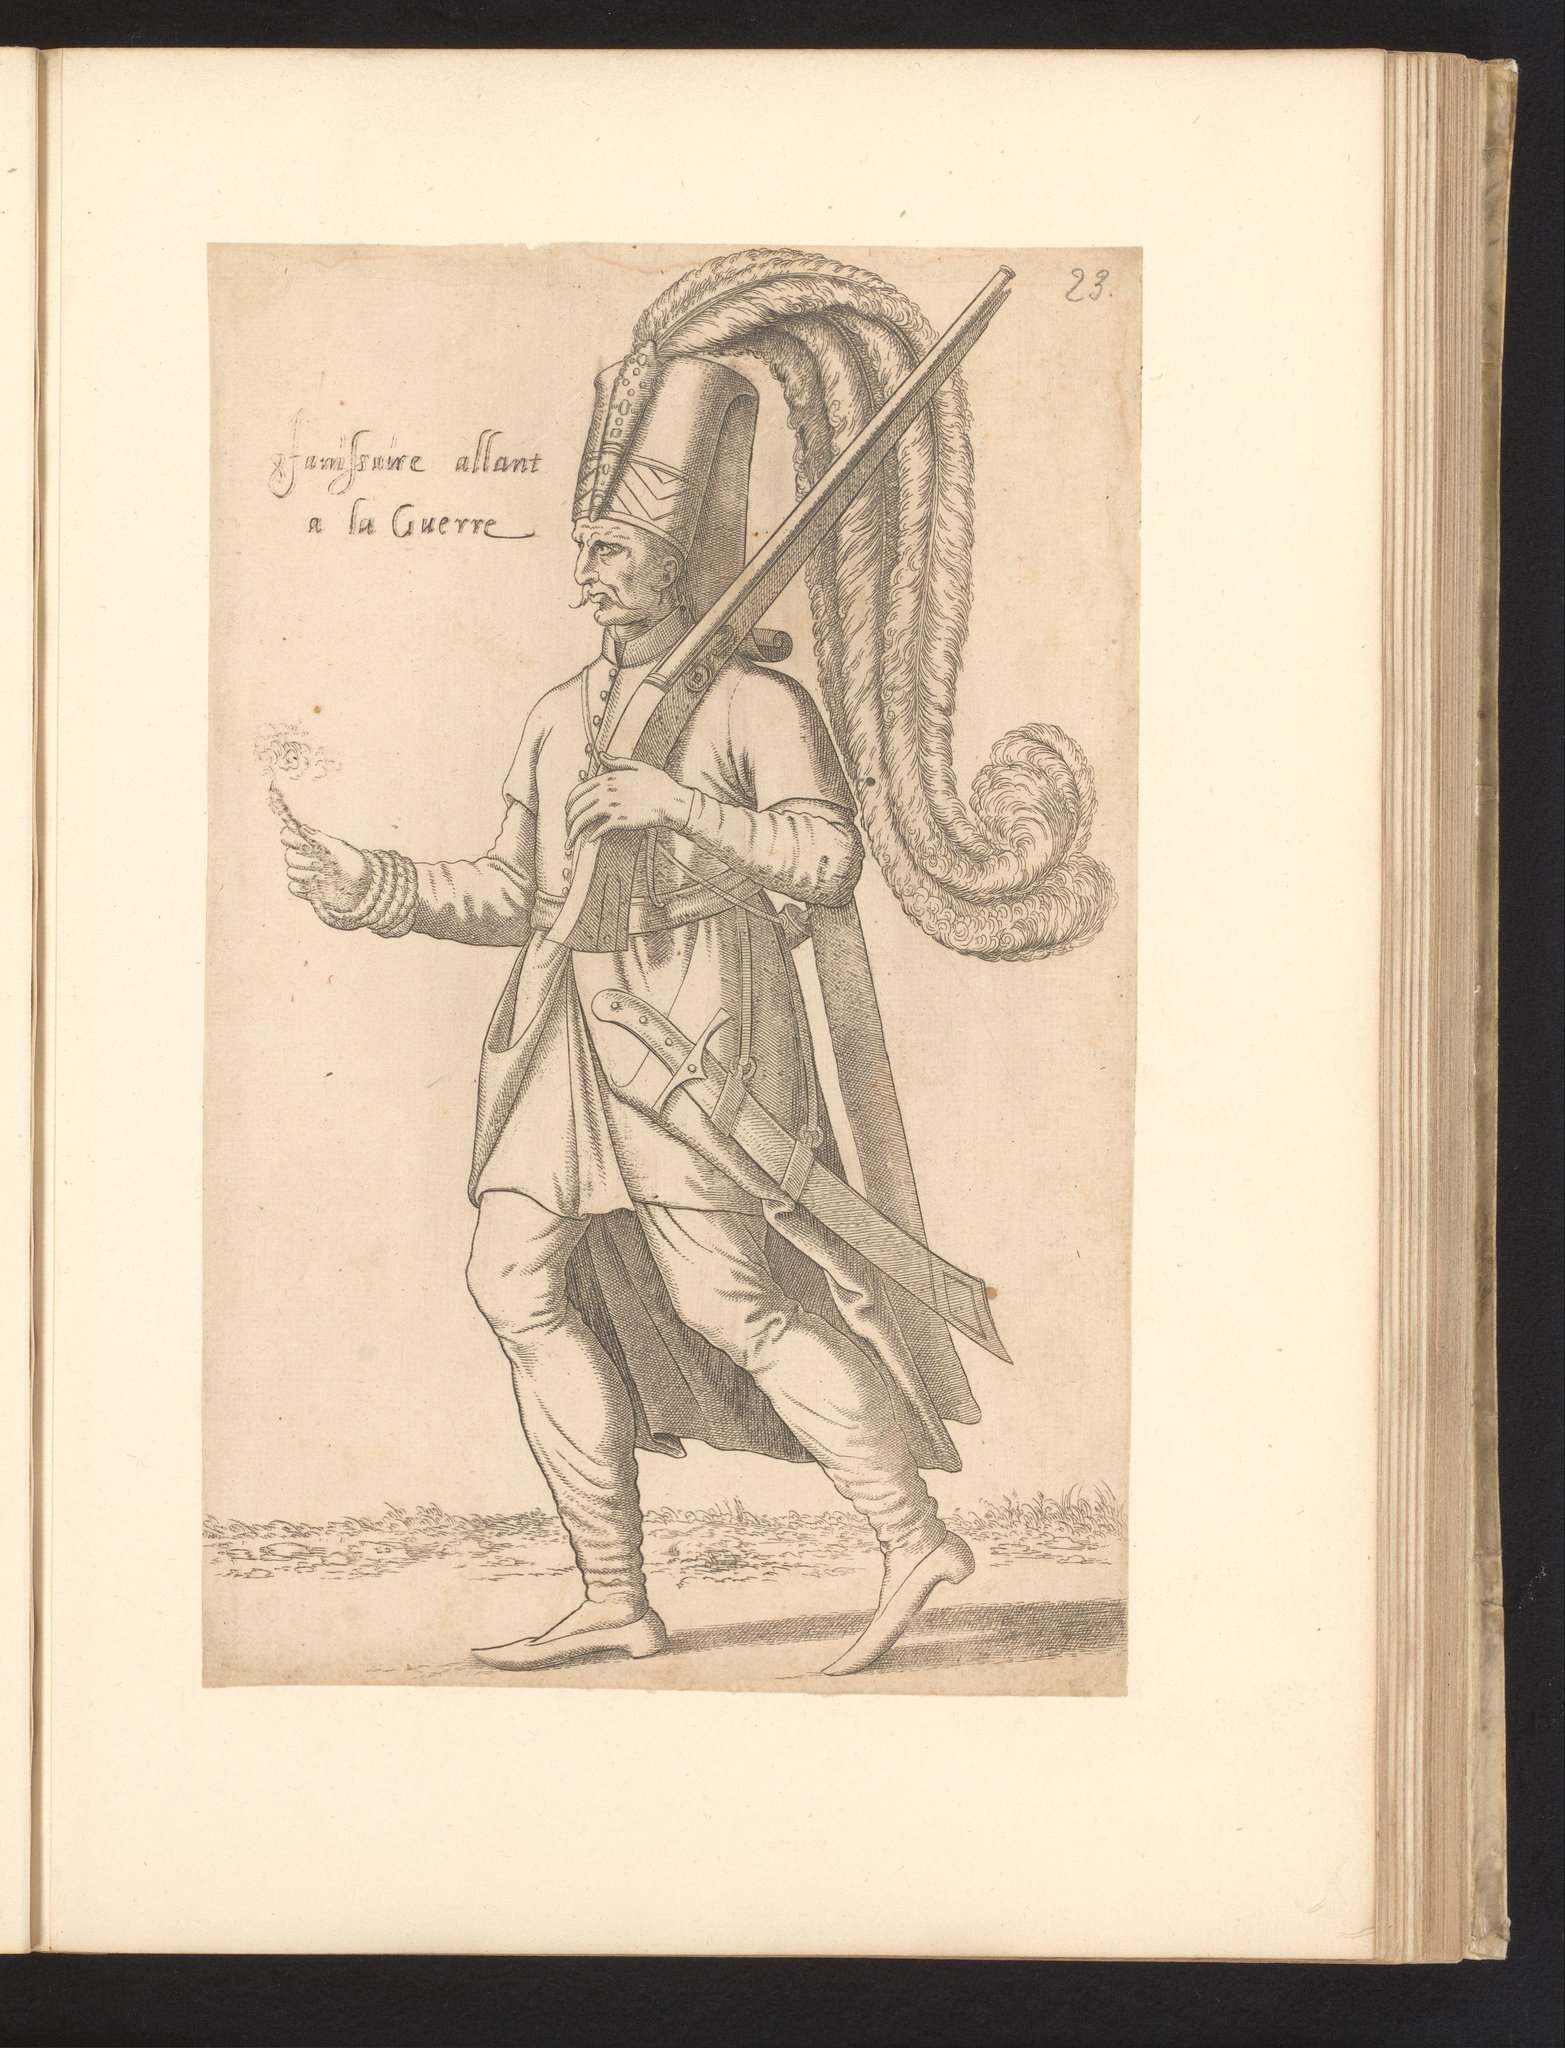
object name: book illustration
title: Janissaire allant à la guerre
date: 1555-1568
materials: paper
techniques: etching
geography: lyon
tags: private soldier (+ infantry), firearms: rifle, asiatic races and peoples: turks (+ costume), head-gear: hat (+ feathers used for clothes)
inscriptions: collector's mark: Lugt 2228, collector's mark: Lugt 2760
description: Prent uit: Nicolay, Nicolas de. Les quatre premiers livres des navigations et pérégrinations orientales, de N. de Nicolay, (...) Avec les figures au naturel tant d'hommes que de femmes selon la diversité des nations, & de leur port, maintien & habitz. Lyon: Guillaume (I) Rouille, 1568.